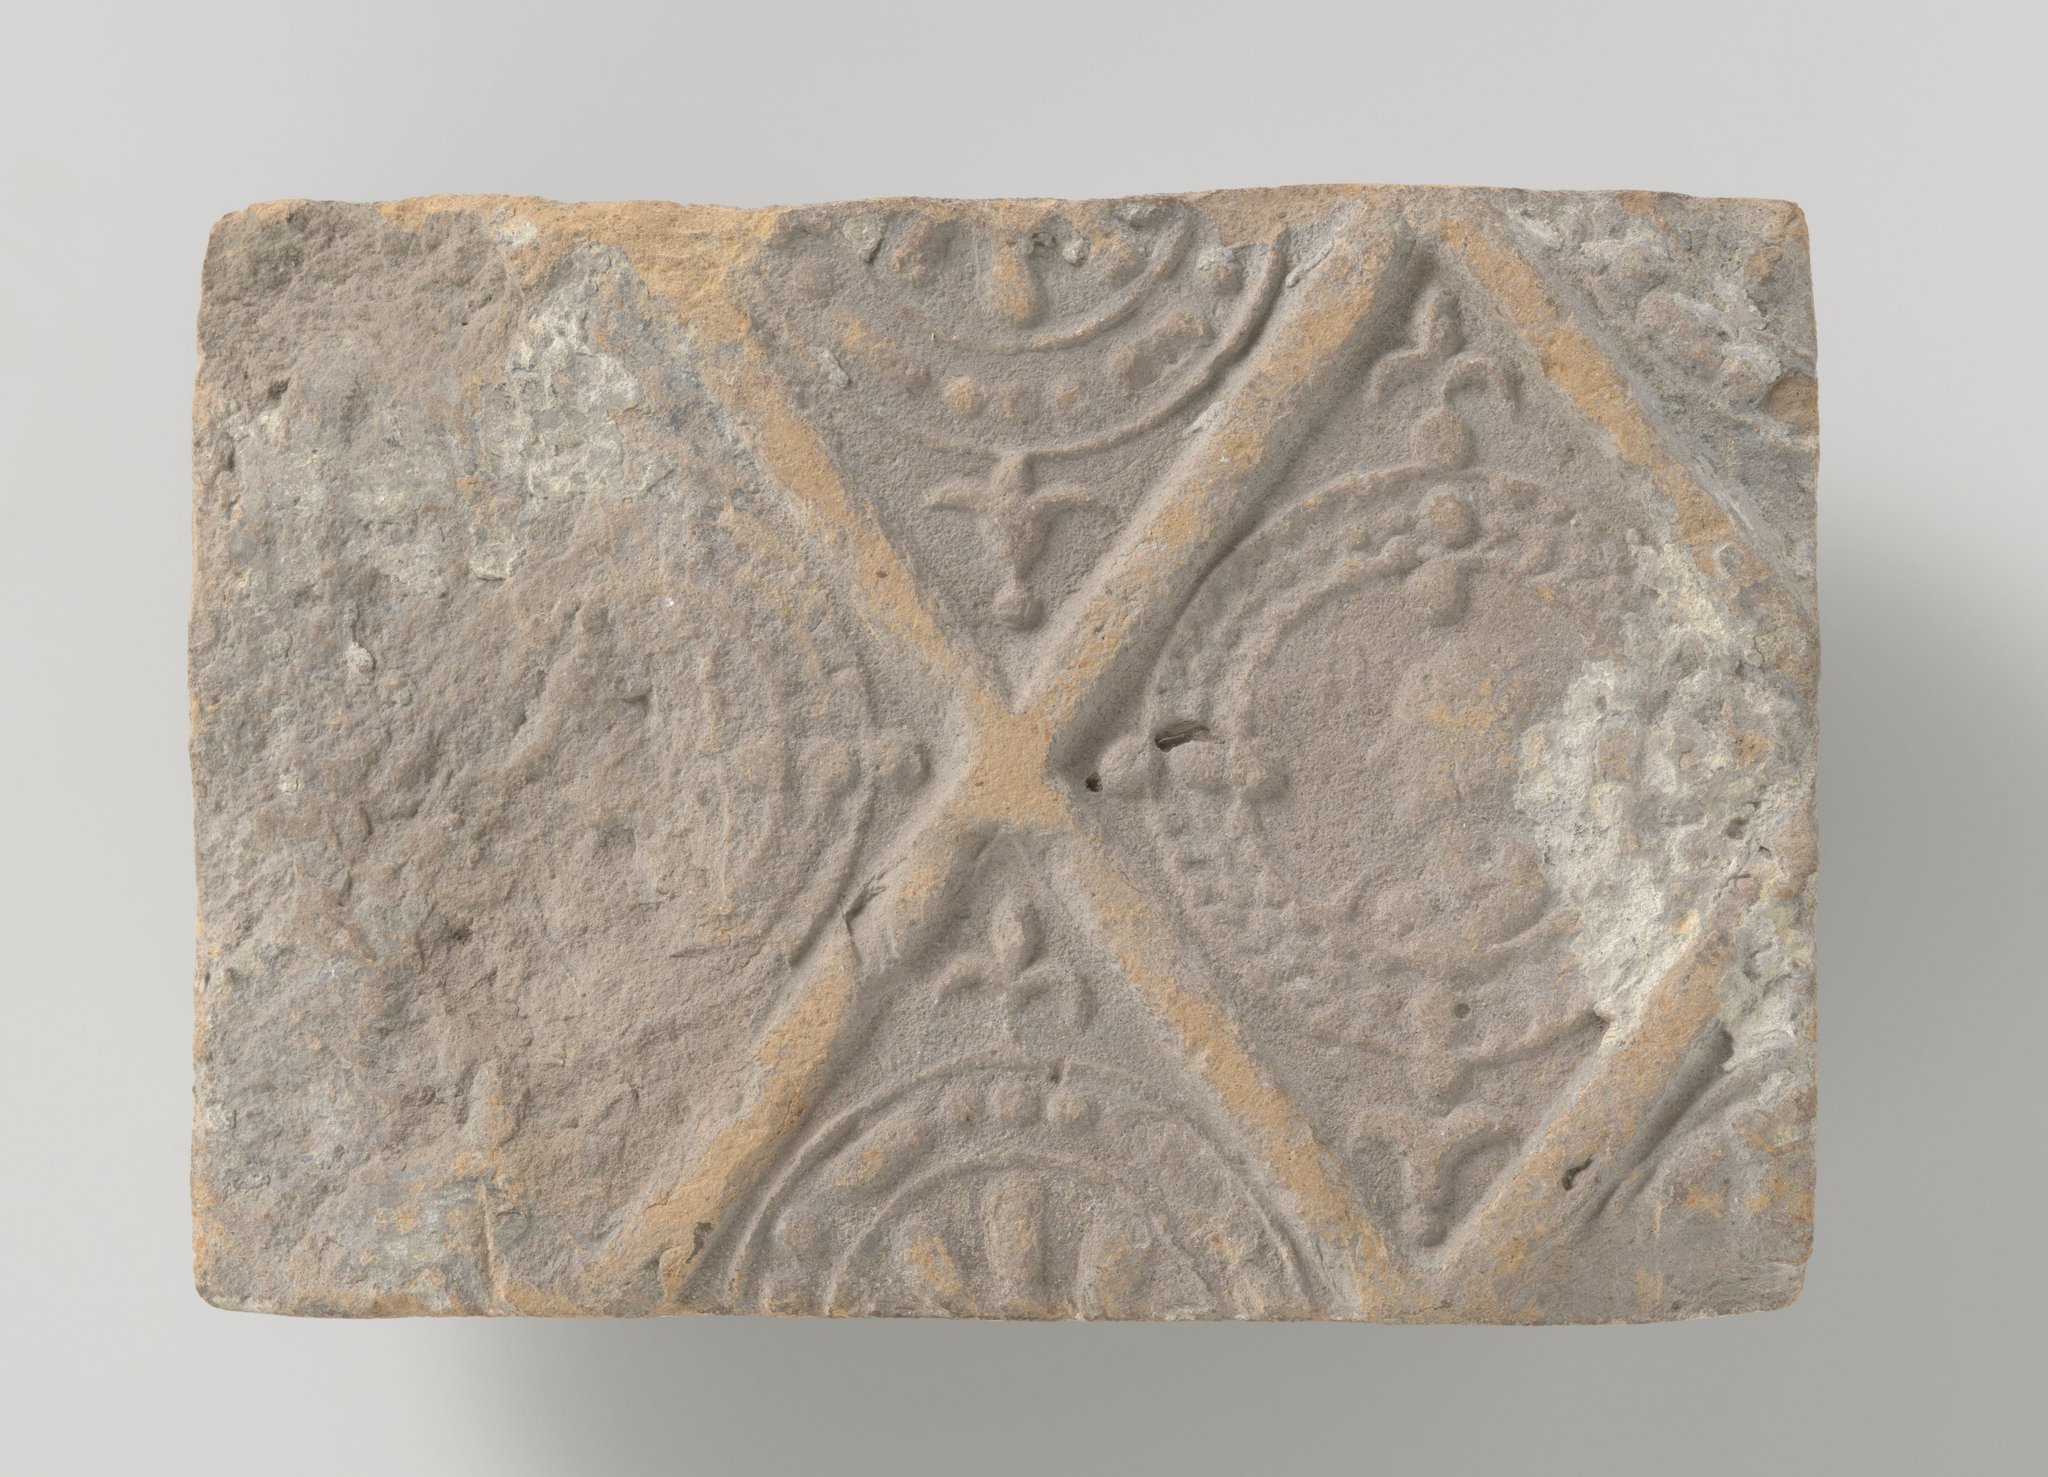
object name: hearthstone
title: Haardsteen met afbeelding van een mannen- en een vrouwenkop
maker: Anonymous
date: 1587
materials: earthenware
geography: southern netherlands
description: Haardsteen van gebakken aarde met twee vorstelijke busten; een man en een vrouw. Met het jaartal 1587.